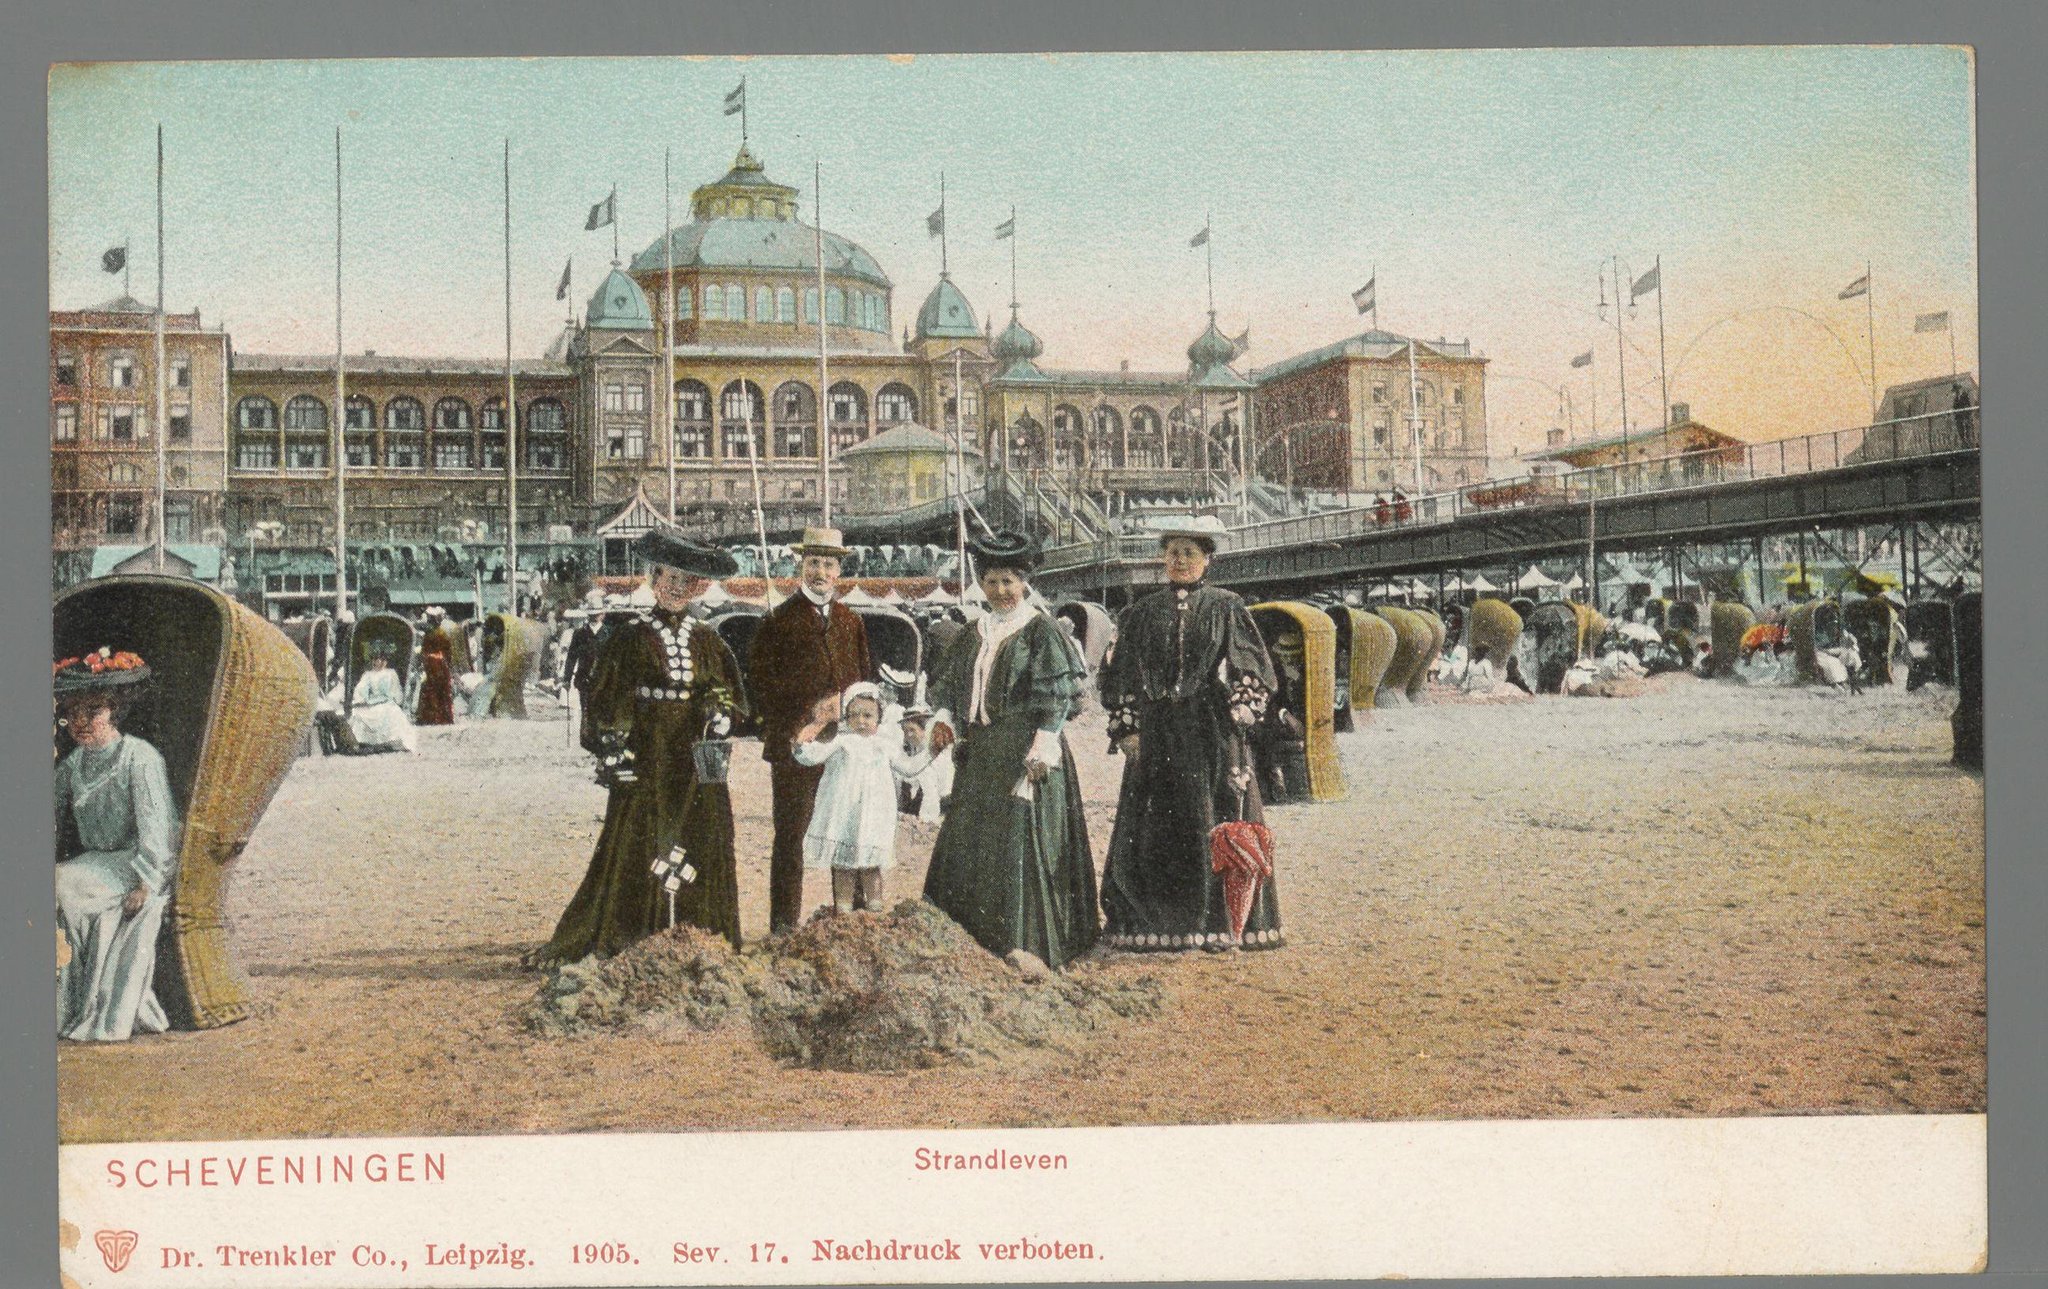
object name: photomechanical print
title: Scheveningen. Strandleven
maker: Anonymous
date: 1905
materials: cardboard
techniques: lithograph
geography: scheveningen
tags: beach (as place of recreation), hotel, hostelry, inn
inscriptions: date